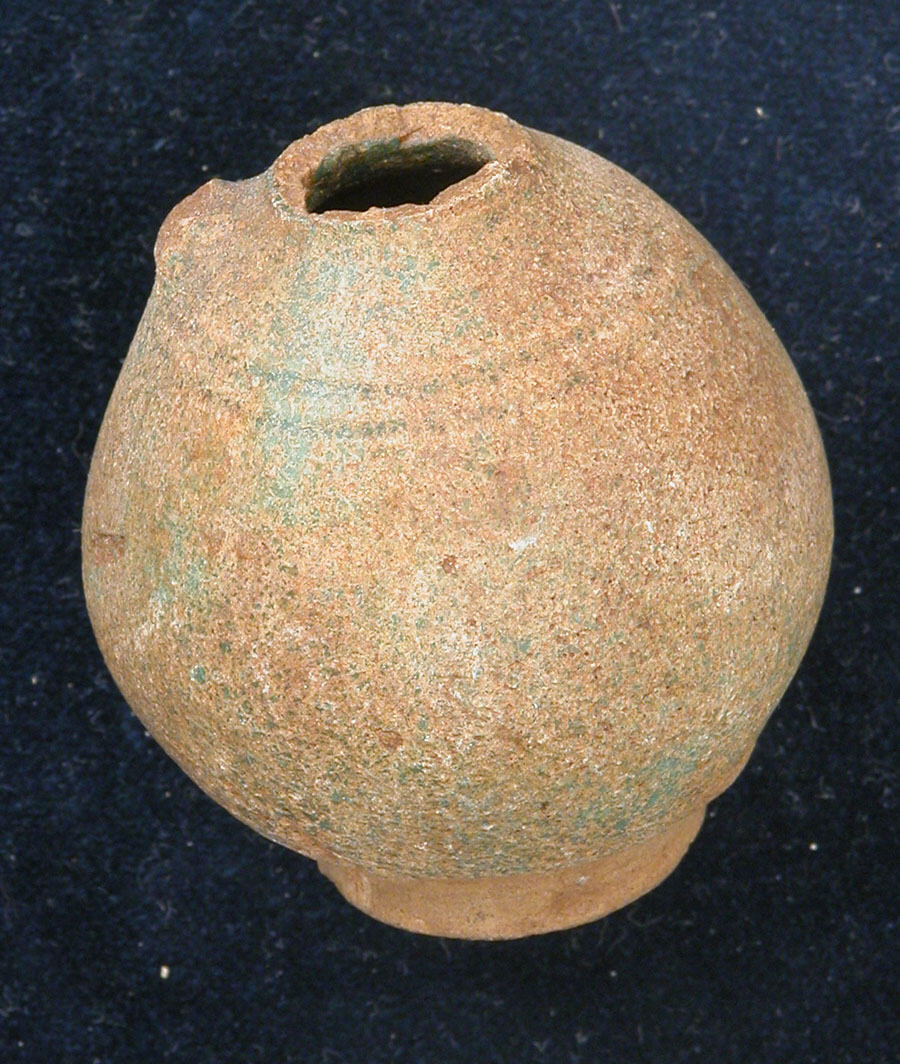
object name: jar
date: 701-1000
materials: earthenware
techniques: glazing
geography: iraq